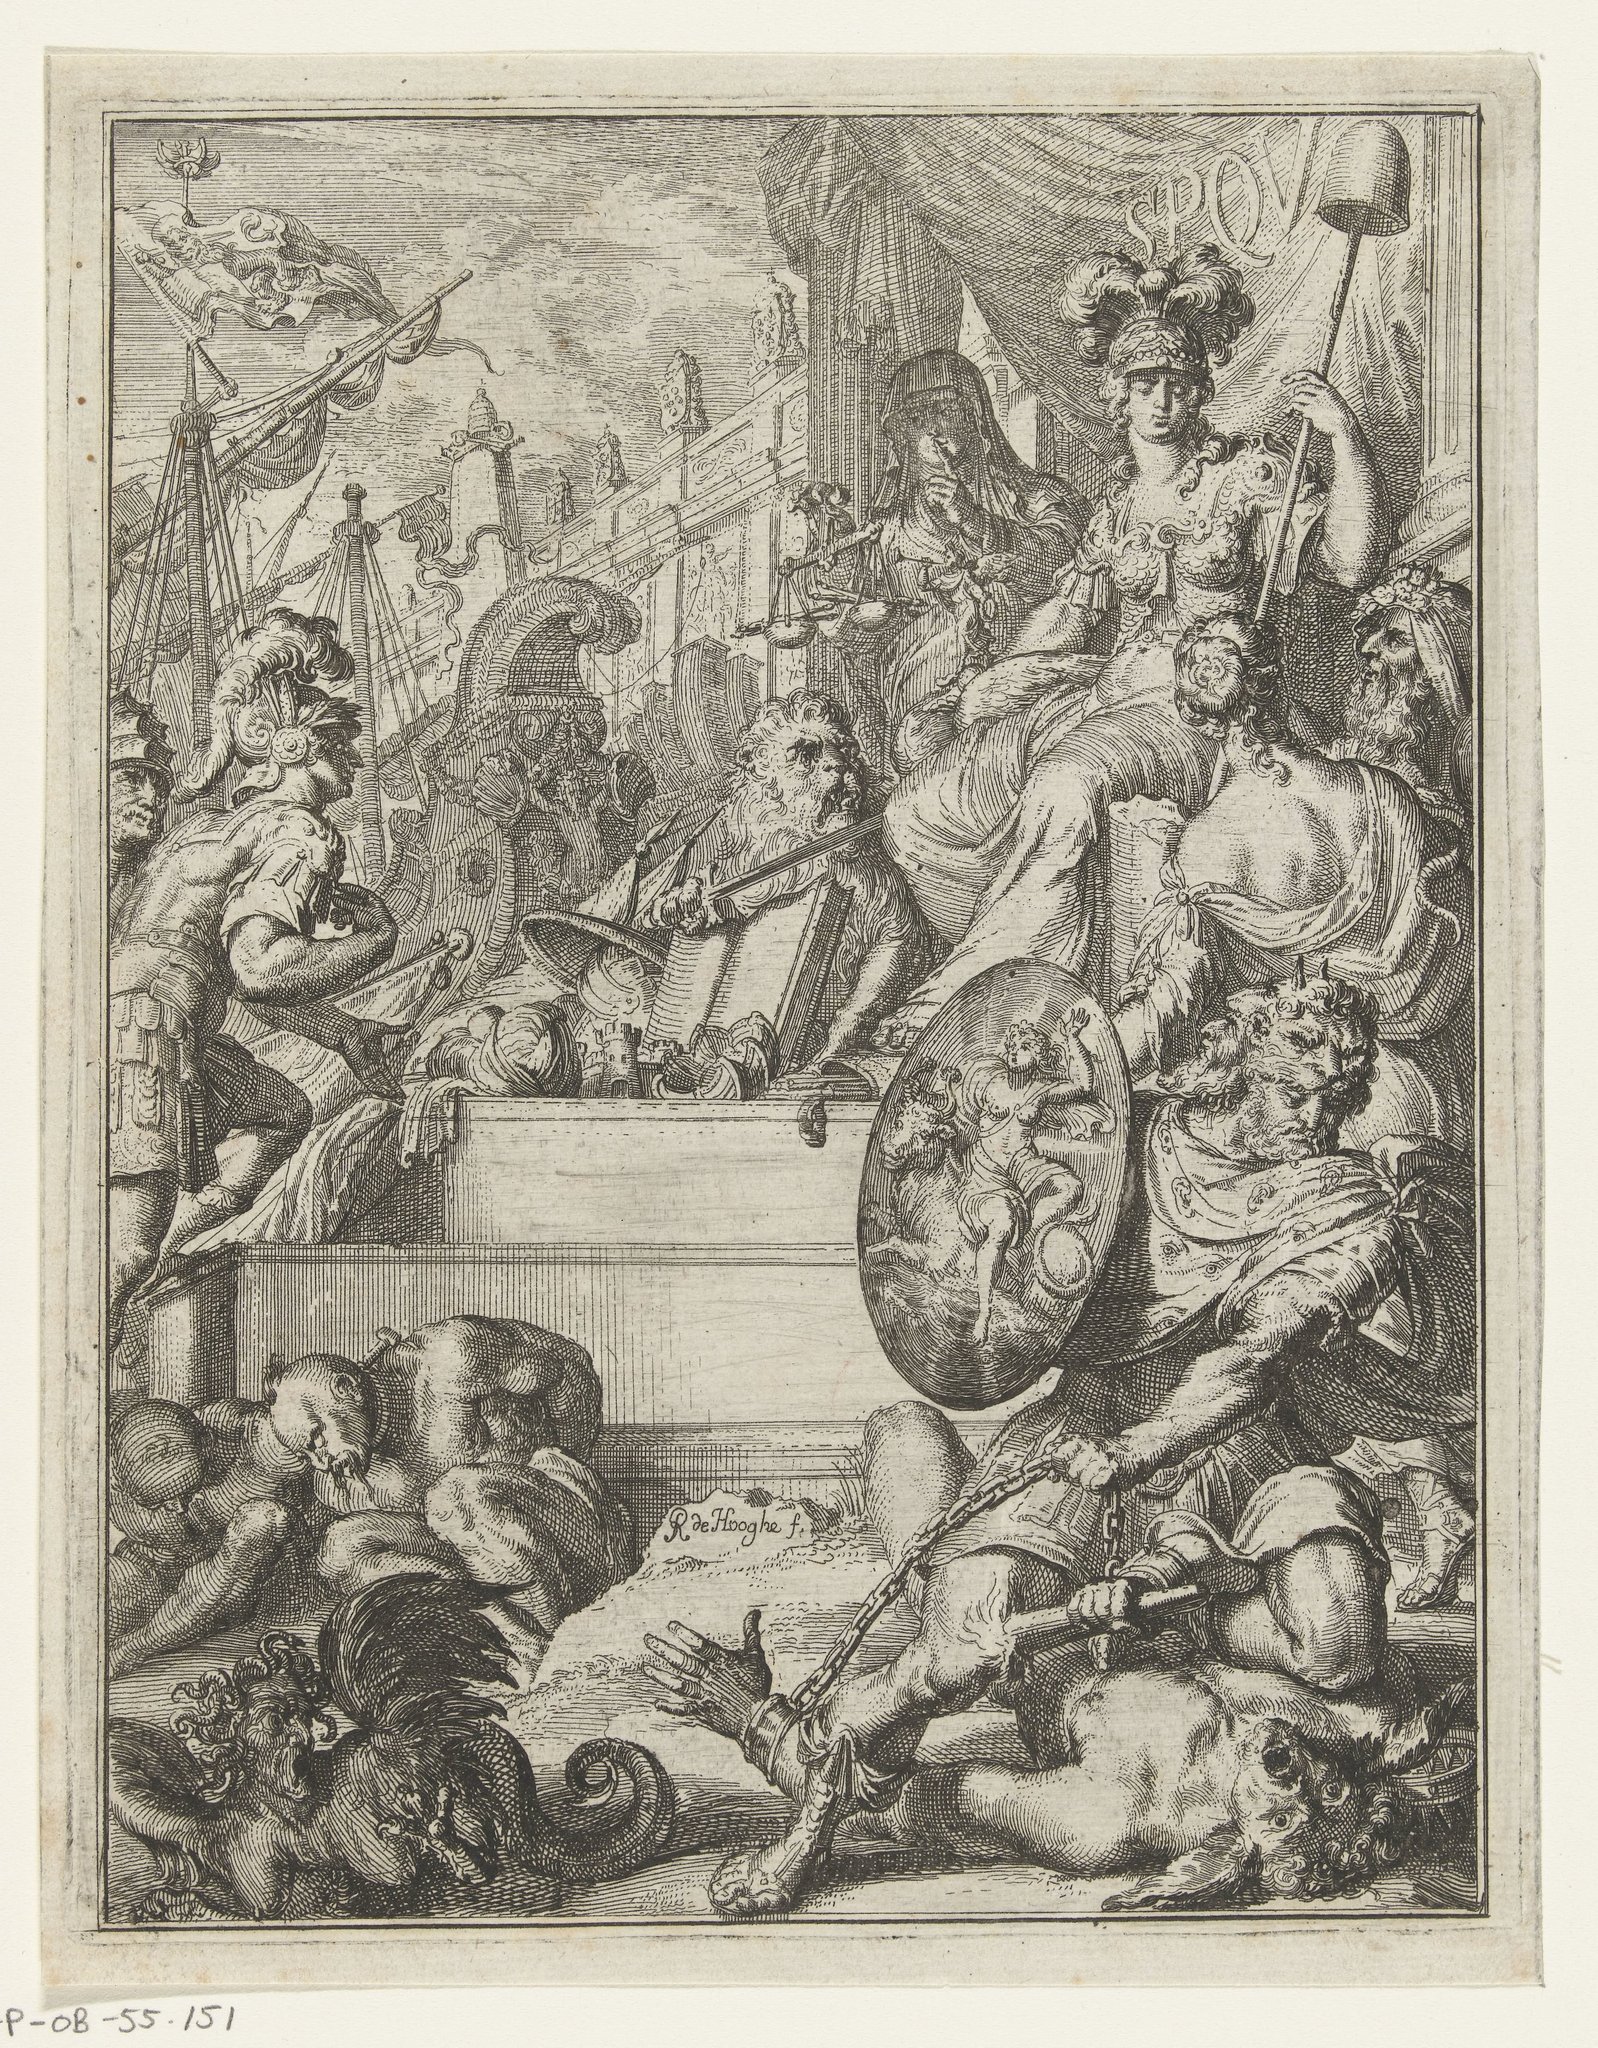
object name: print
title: Allegorische voorstelling met getroonde vrouw in harnas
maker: romeyn de hooghe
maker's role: draughtsman, goldsmith, painter, print maker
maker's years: 1645-1708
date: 1677-1690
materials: paper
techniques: engraving, etching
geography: netherlands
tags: jupiter, usually in the shape of a white bull, abducts europa and carries her across the water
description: Allegorische voorstelling met getroonde vrouw in harnas en vrijheidshoed op haar staf. Aan haar voeten een leeuw met zwaard en boek. Achter haar de letters SPQV (een verwijzing naar Venetië?).